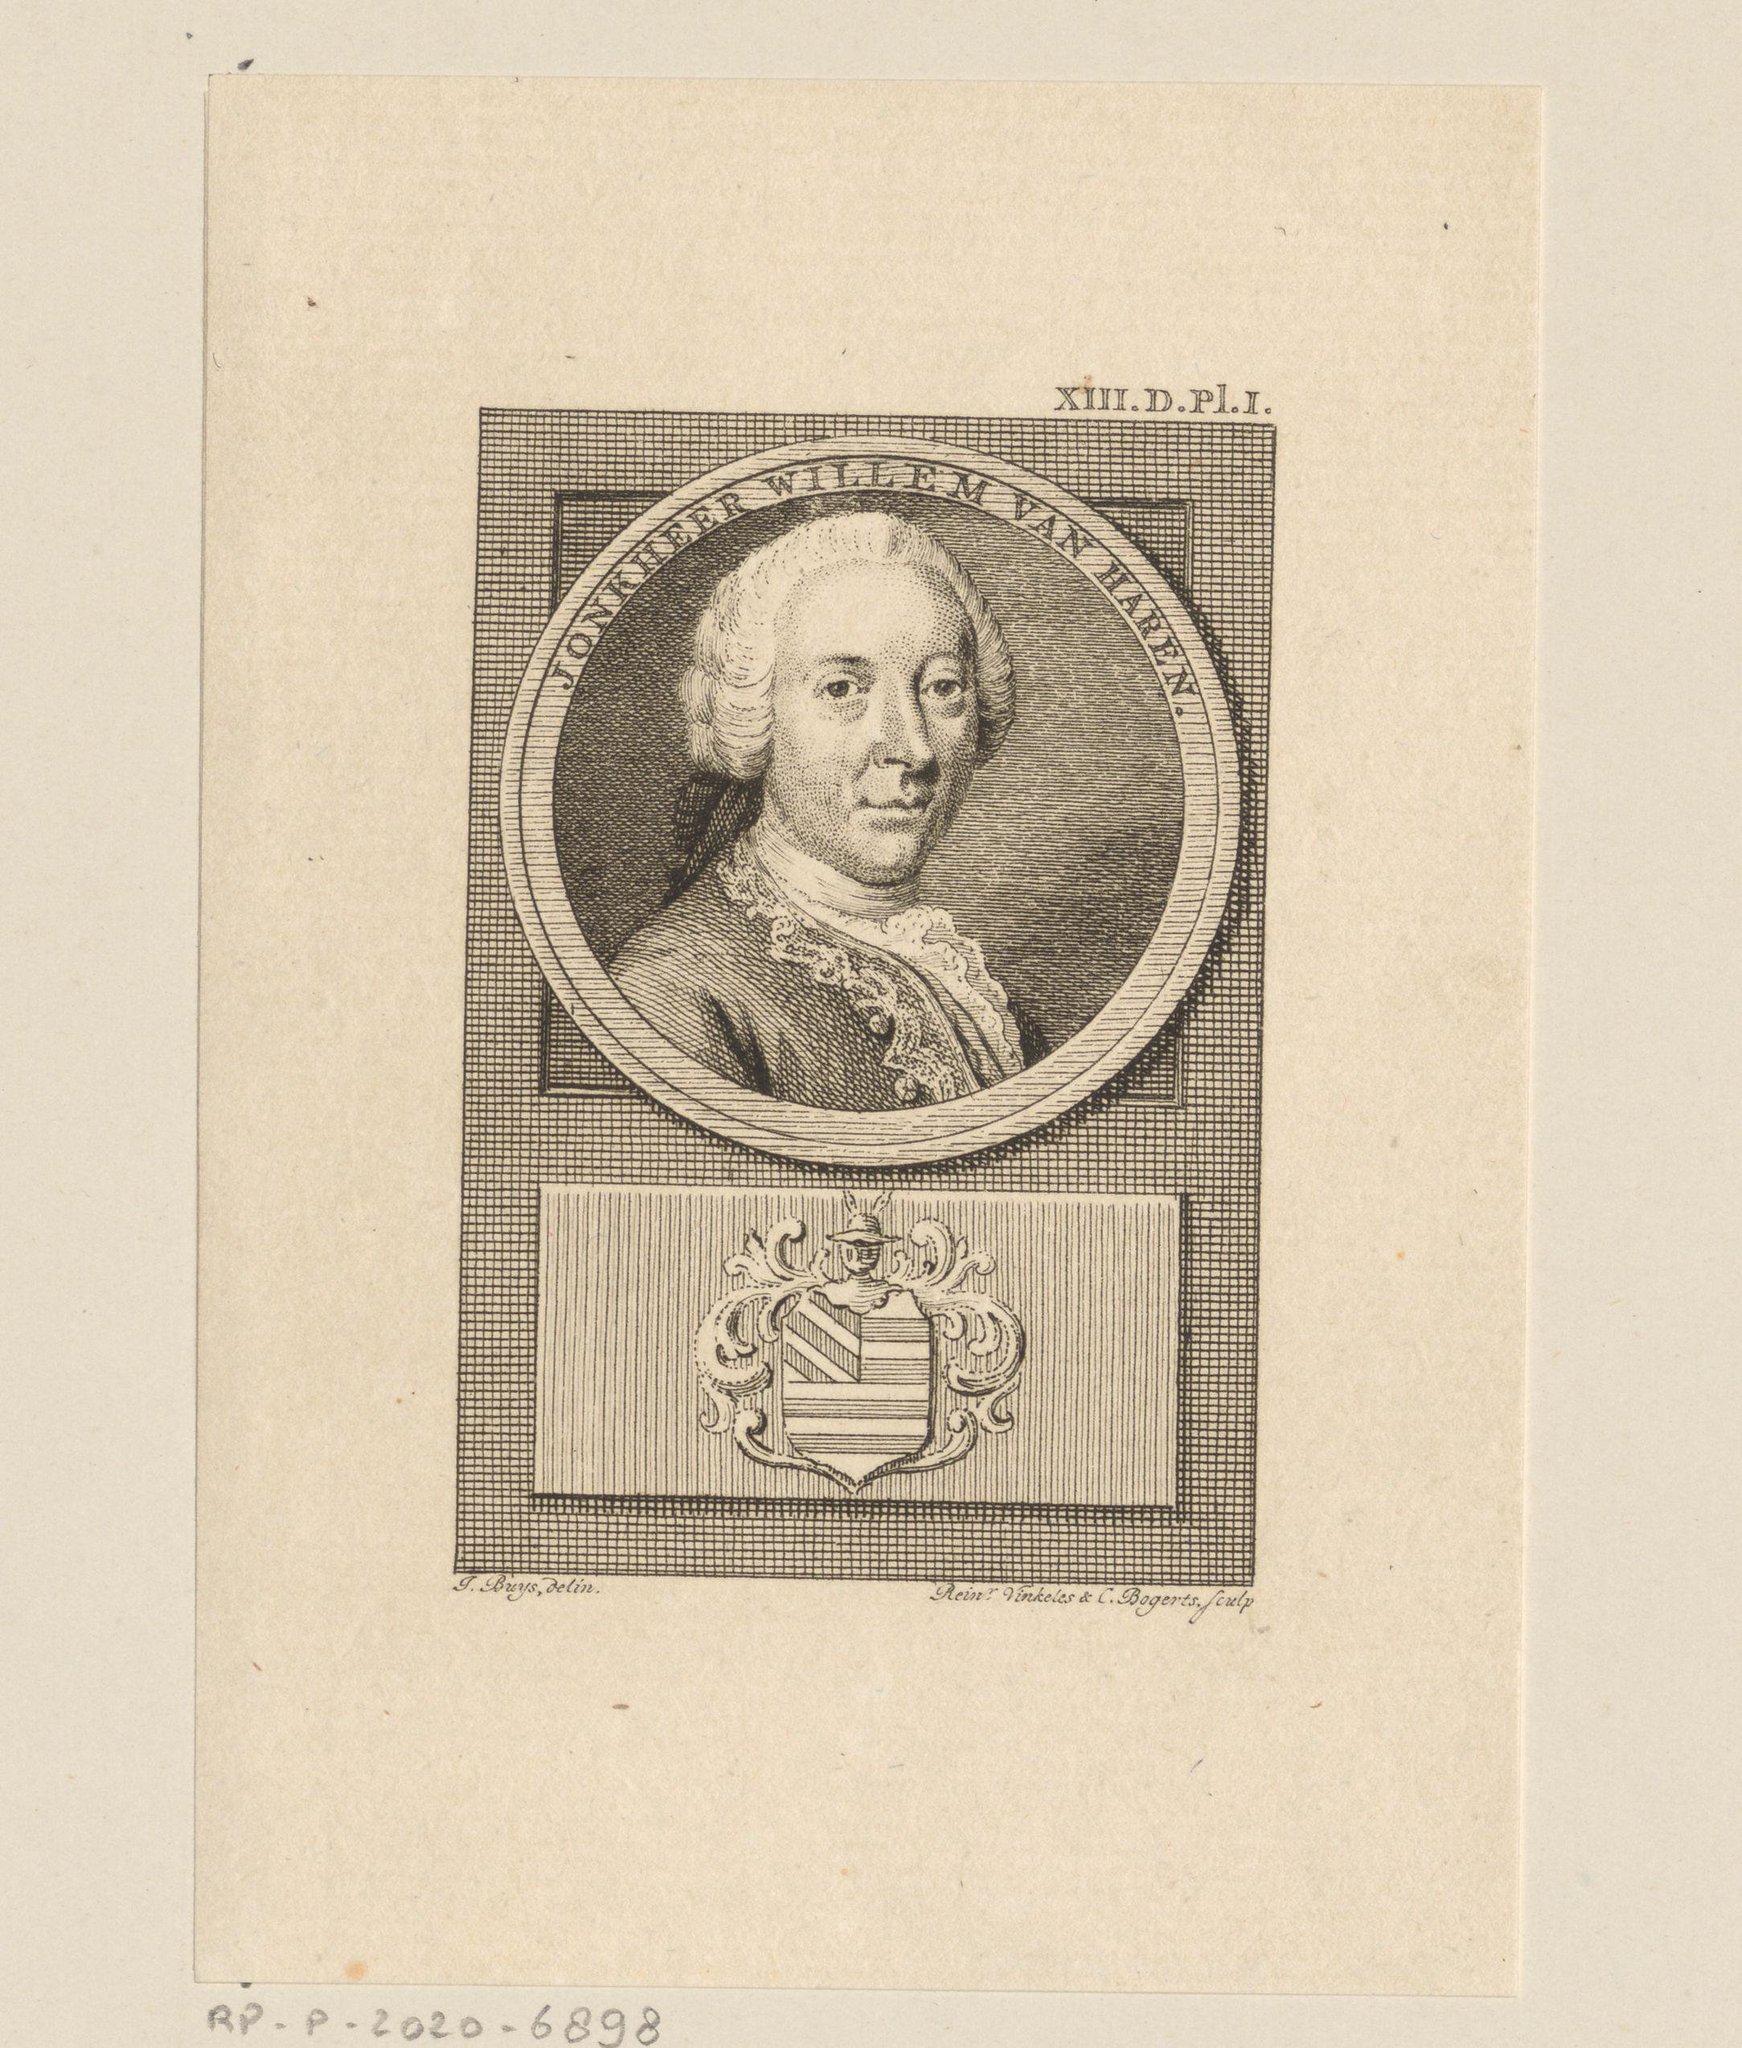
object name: book illustration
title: Portret van Willem van Haren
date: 1783-1795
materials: paper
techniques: engraving, etching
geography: amsterdam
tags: historical persons, writer, poet, author, armorial bearing, heraldry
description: Prent uit: Fokke, Jan. Geschiedenissen der Vereenigde Nederlanden voor de vaderlandsche jeugd (...). Amsterdam: Johannes Allart, 1783-1795, dl. 13.